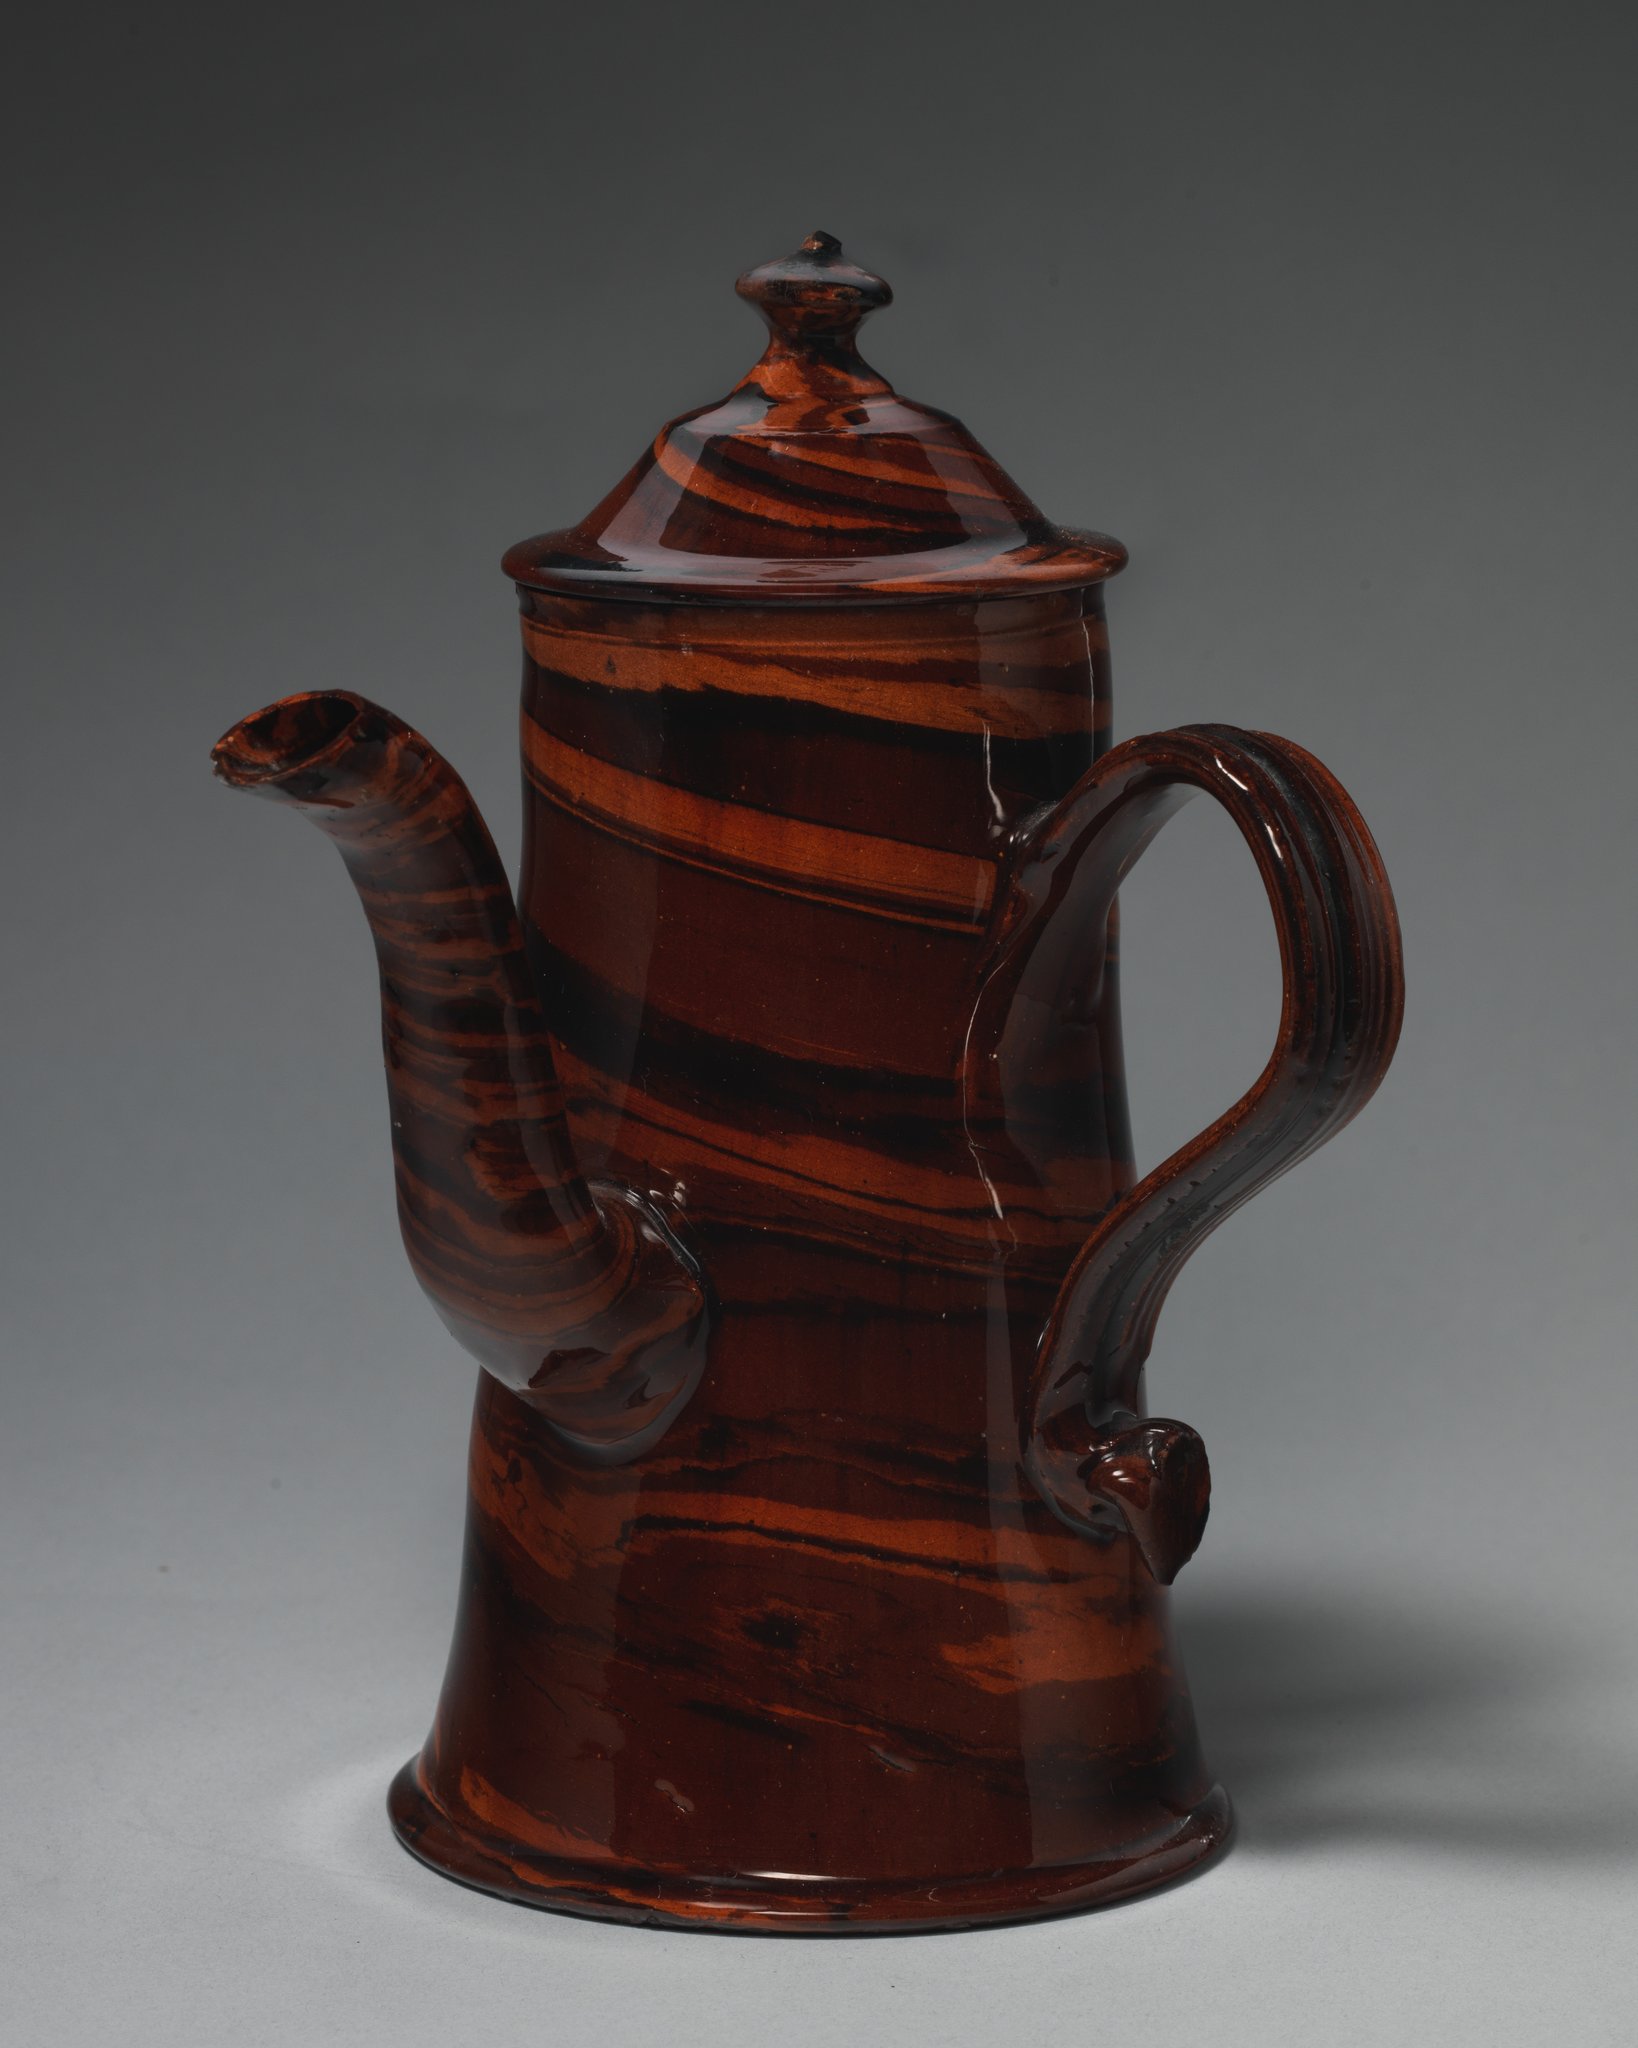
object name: coffeepot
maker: john astbury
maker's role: maker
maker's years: 1688-1743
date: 1745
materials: earthenware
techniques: glazing